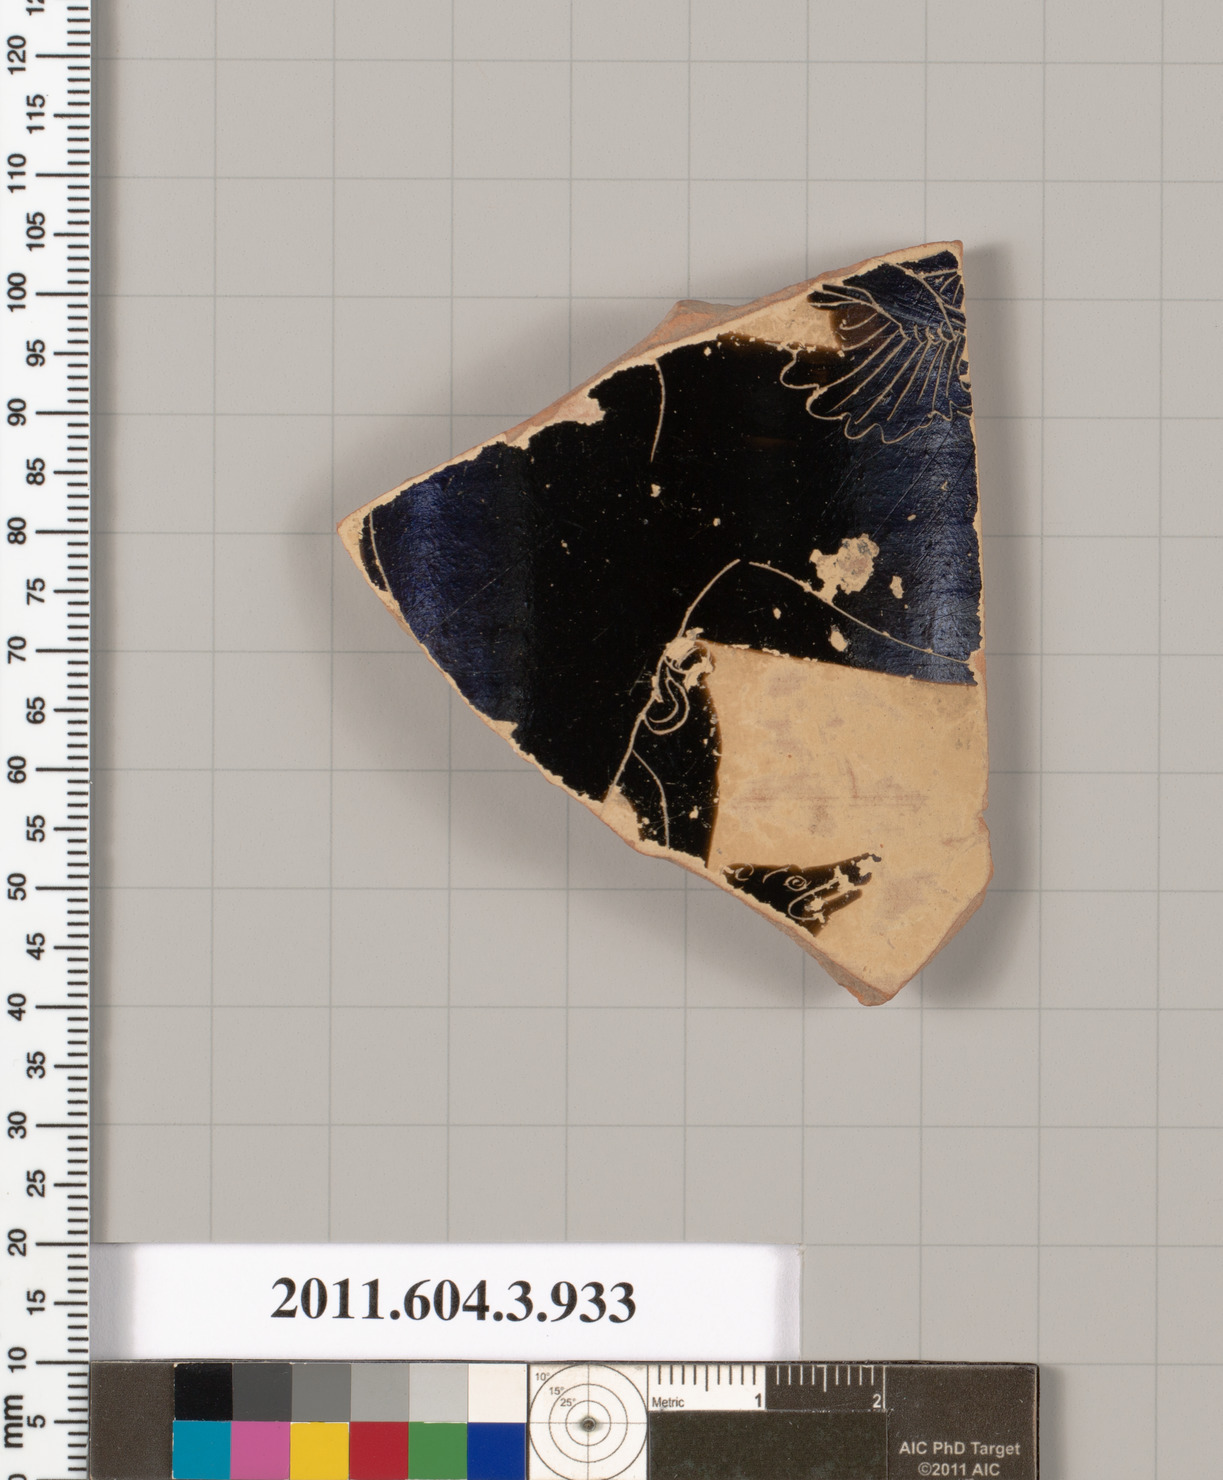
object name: lekythos fragment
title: Terracotta fragment of a lekythos (oil flask)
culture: greek, attic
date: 534-468 BCE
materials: terracotta